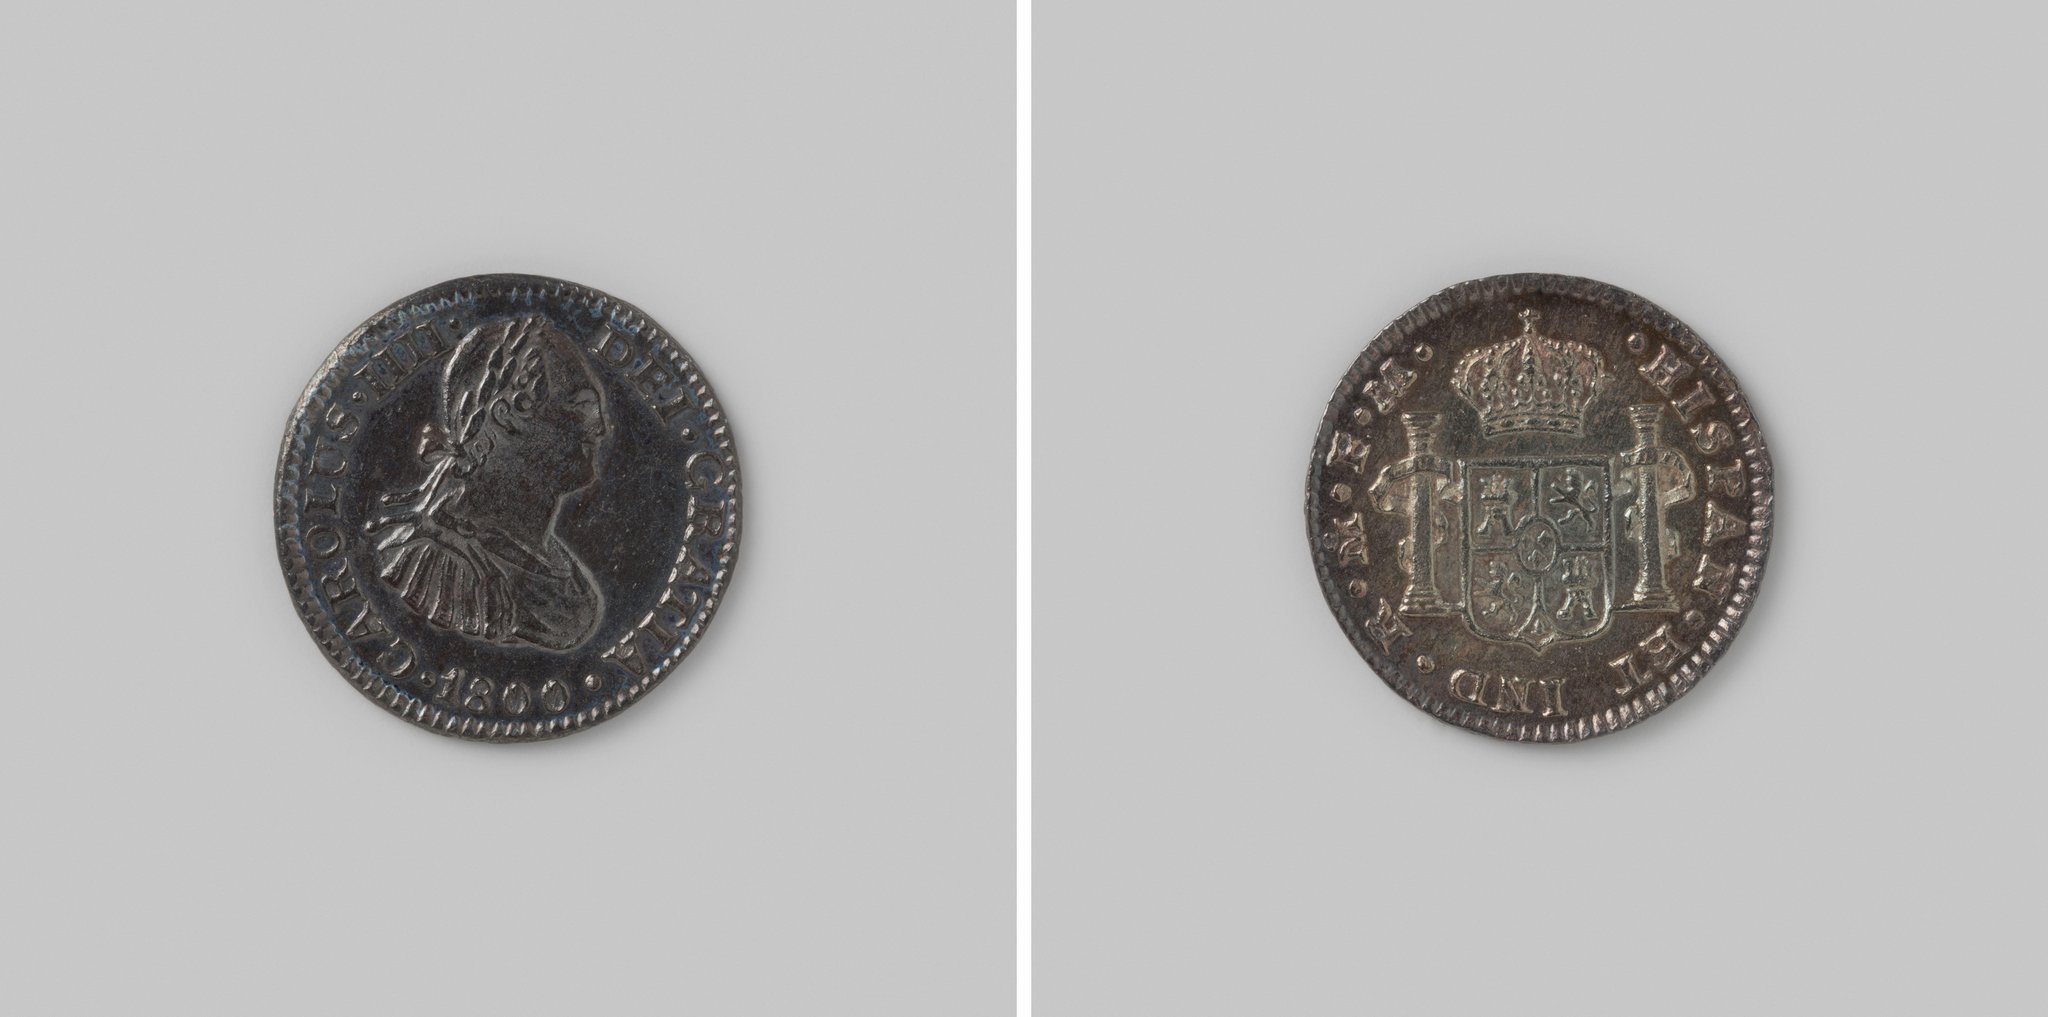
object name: halve reaal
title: ½ reaal uit Mexico van koning Karel IV,1800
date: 1800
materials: silver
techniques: striking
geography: mexico city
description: Zilveren munt. Voorzijde: gelauwerd hoofd van de koning naar rechts. Jaartal onderaan. Keerzijde: tussen twee uit zee oprijzende zuilen, waarop banderol met opschrift, gekroond samengesteld wapenschild. Muntplaats-aanduiding: Mo. en waarde-aanduiding: M [=medio] in omschrift. Versierde rand.